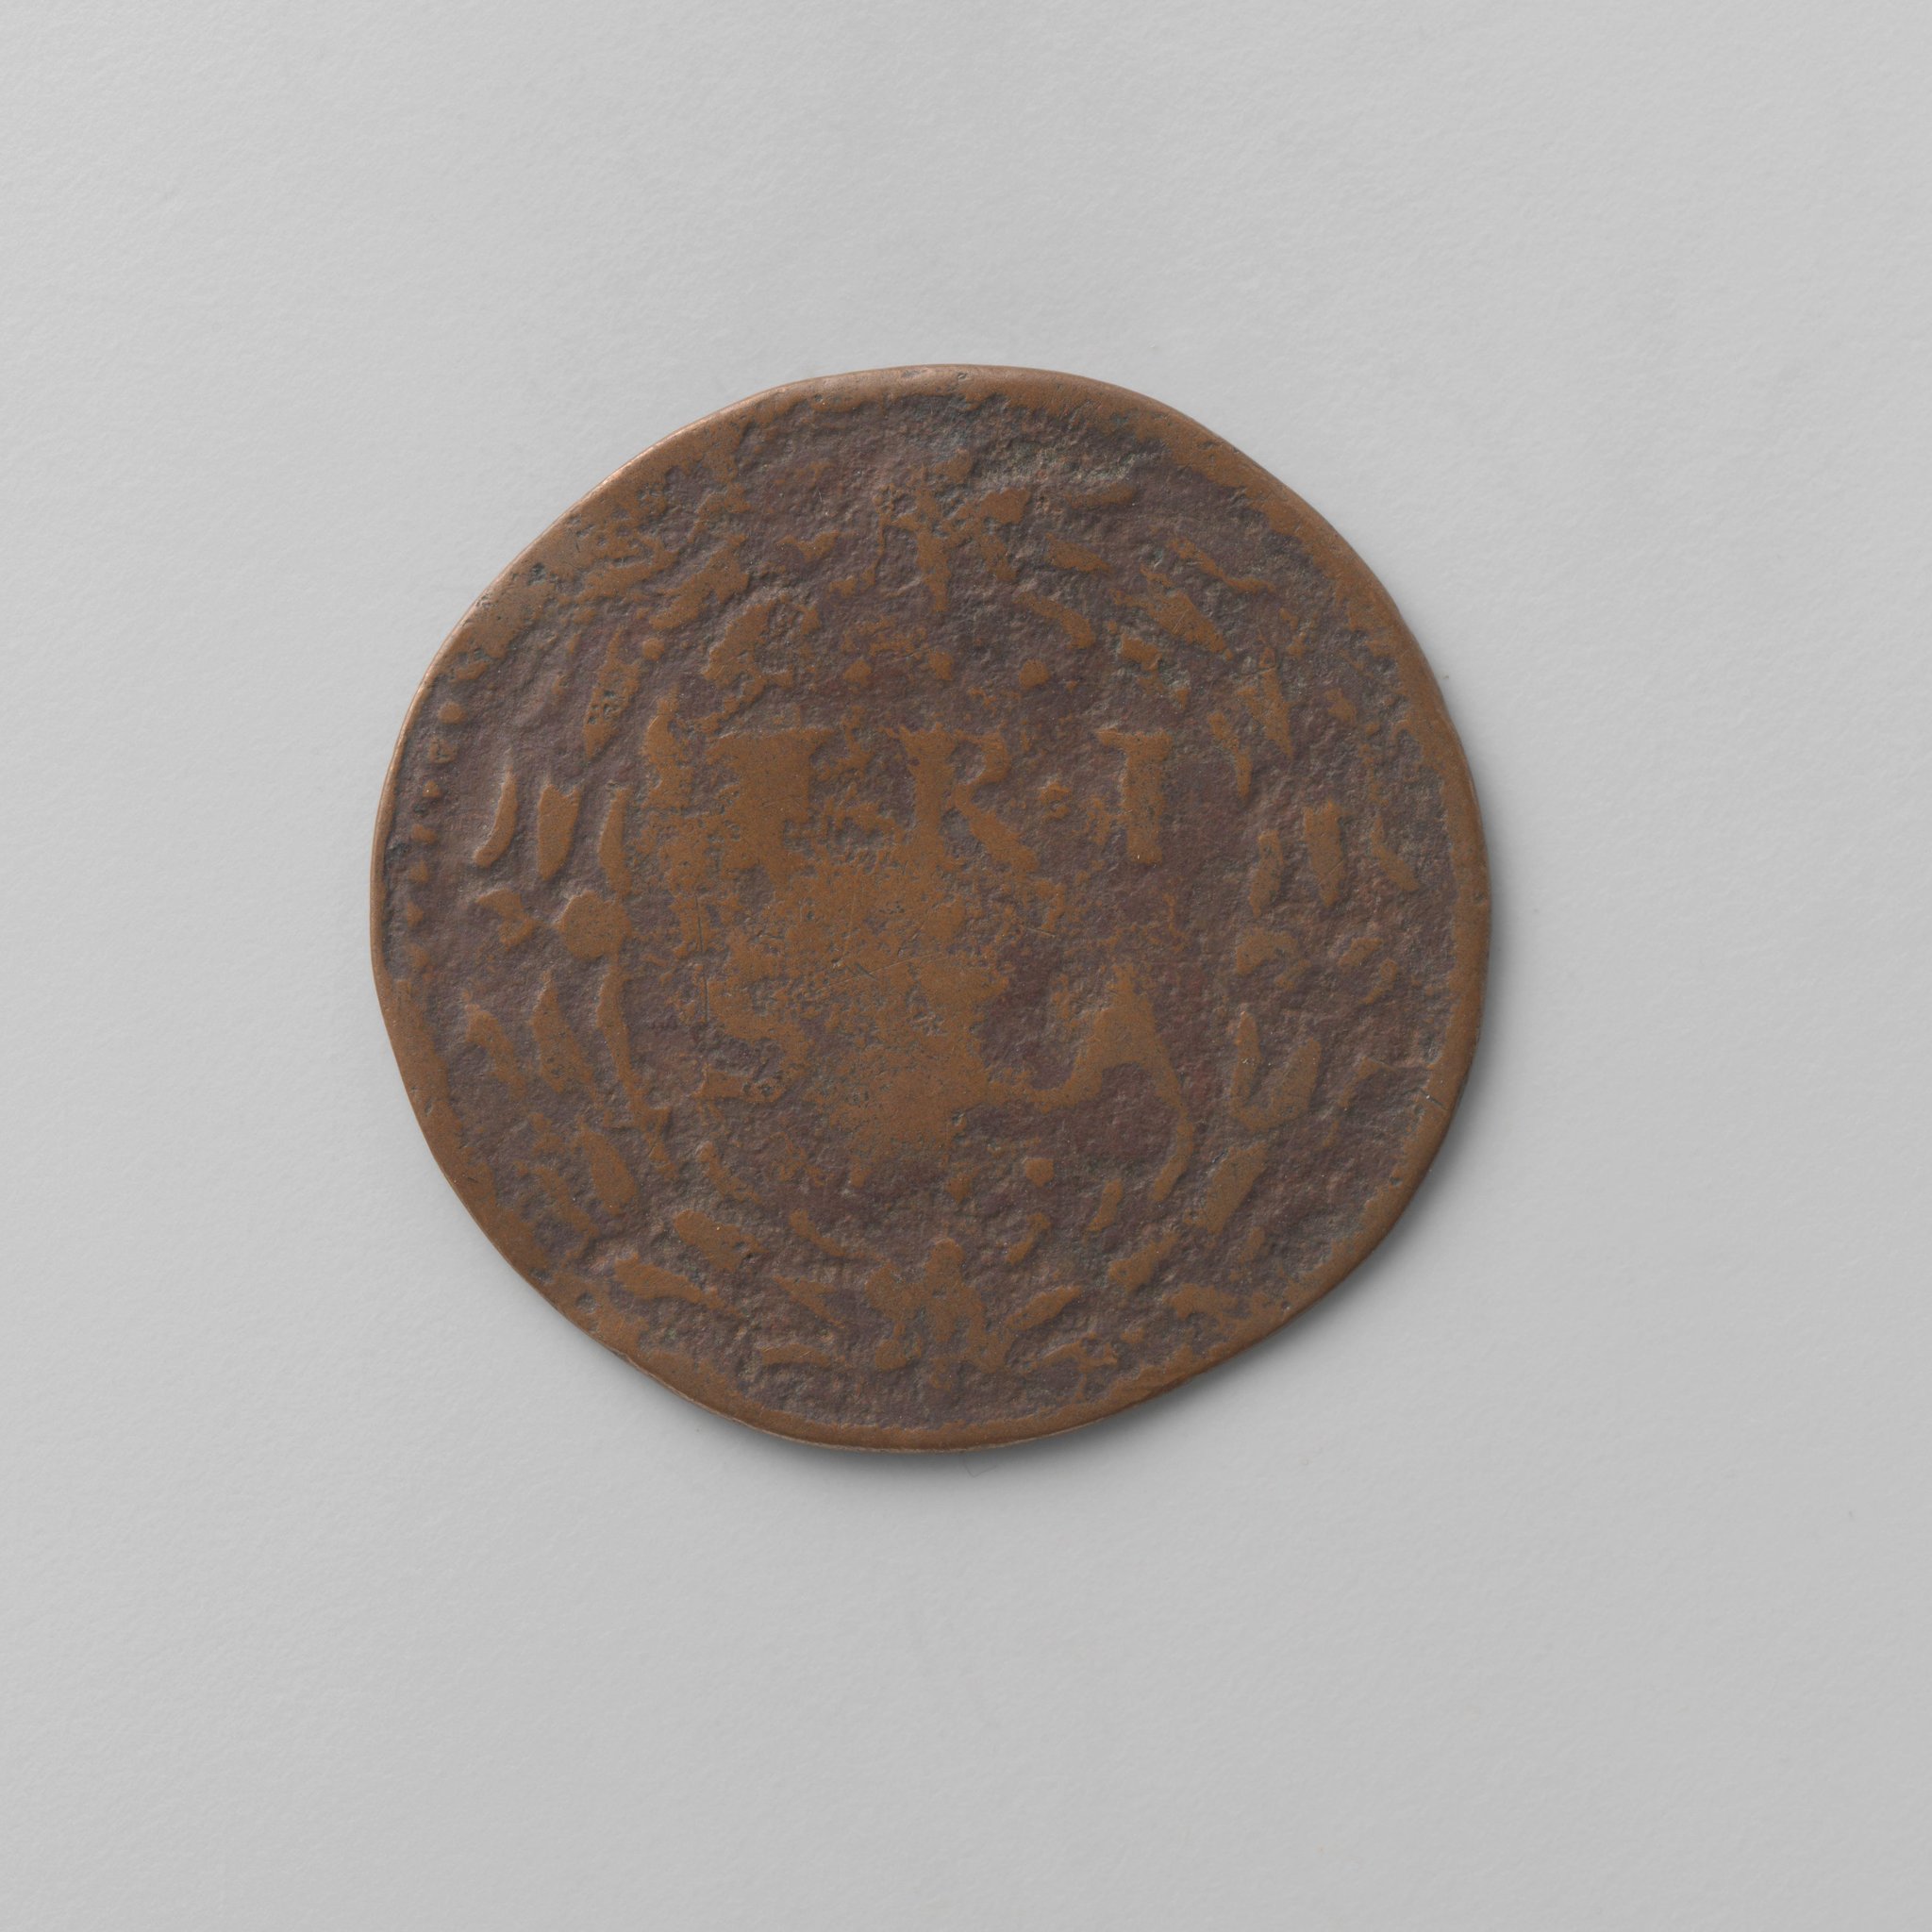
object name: coin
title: Friesland, duit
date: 1600-1605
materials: copper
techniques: striking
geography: leeuwarden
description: Koperen munt. Voorzijde: gekroond ingebogen wapenschild van Friesland. Keerzijde: in een bladerkrans opschrift in twee regels.